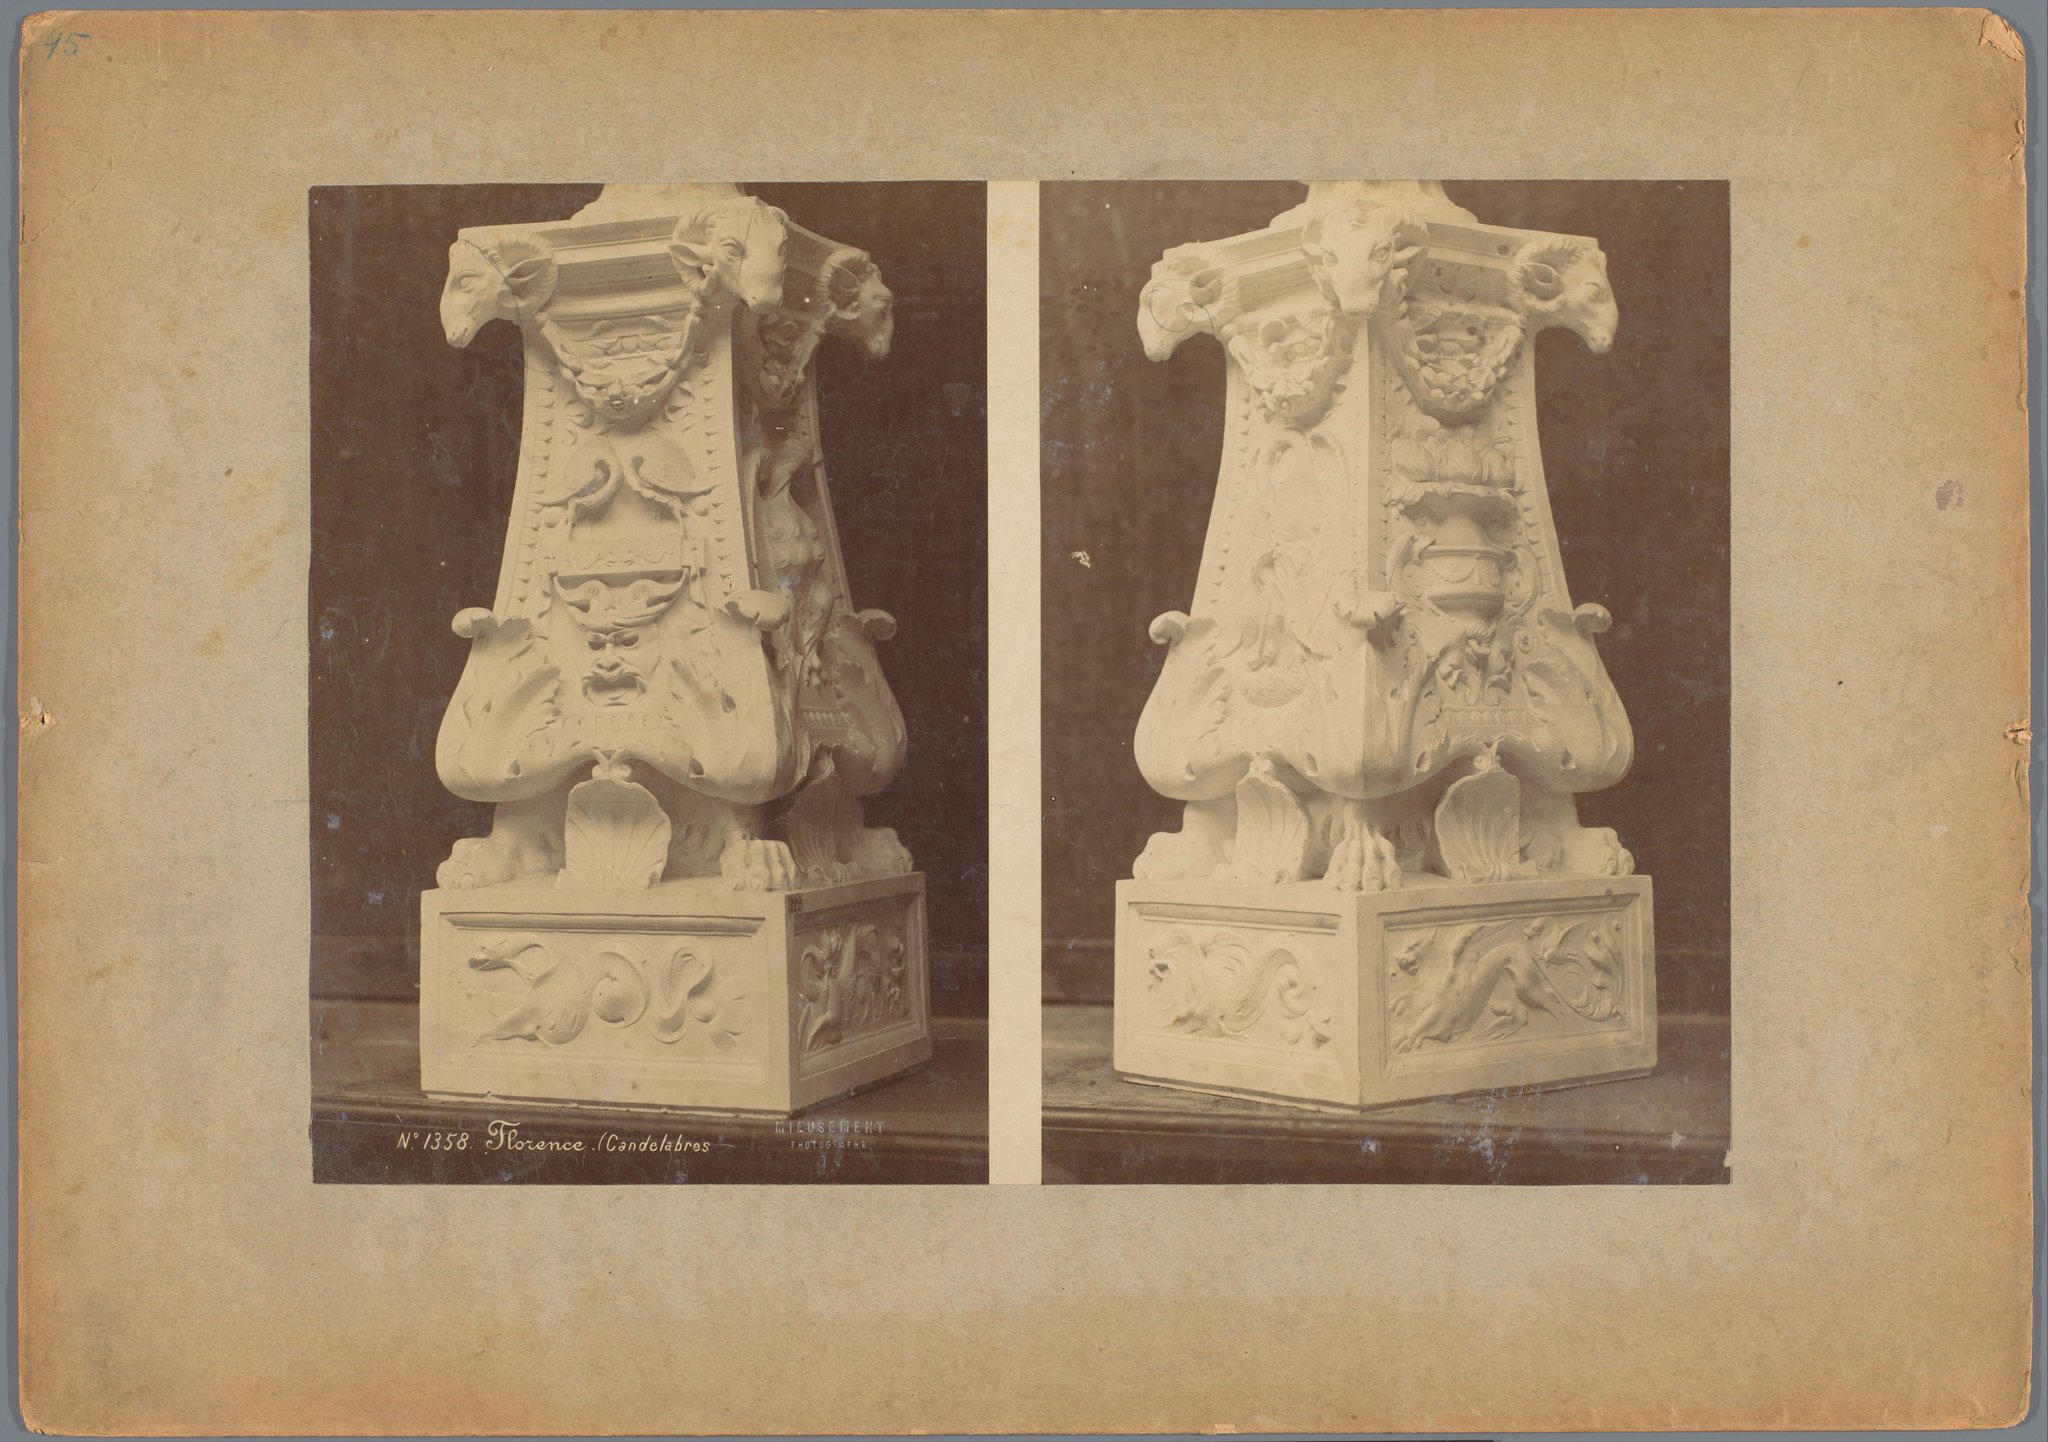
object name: photograph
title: Twee aanzichten van de piëdestal van een kandelaber, afkomstig van de San Lorenzo te Florence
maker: séraphin-médéric mieusement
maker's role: fotograaf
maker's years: 1840-1905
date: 1875-1900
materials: cardboard, photographic support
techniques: albumen print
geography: sint-laurensbasiliek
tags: ram's head ~ ornament, chandelier, candelabrum, monsters of the sea, sculpture (+ relief ~ sculpture)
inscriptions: inscription: ‘MONUMENTS HISTORIQUES’, name: ‘MIEUSEMENT PHOTOGRAPHE’, collector's mark: ‘RIJKS-NORMAALSCHOOL voor TEEKENONDERWIJZERS AMSTERDAM’, number: ‘No. 1358’, name: ‘KUNSTBOEKHANDEL J. A. G. DE LEUR PHOTOGRAAF - UITGEVER HUIGENSPARK, 40b. DEN HAAG.’